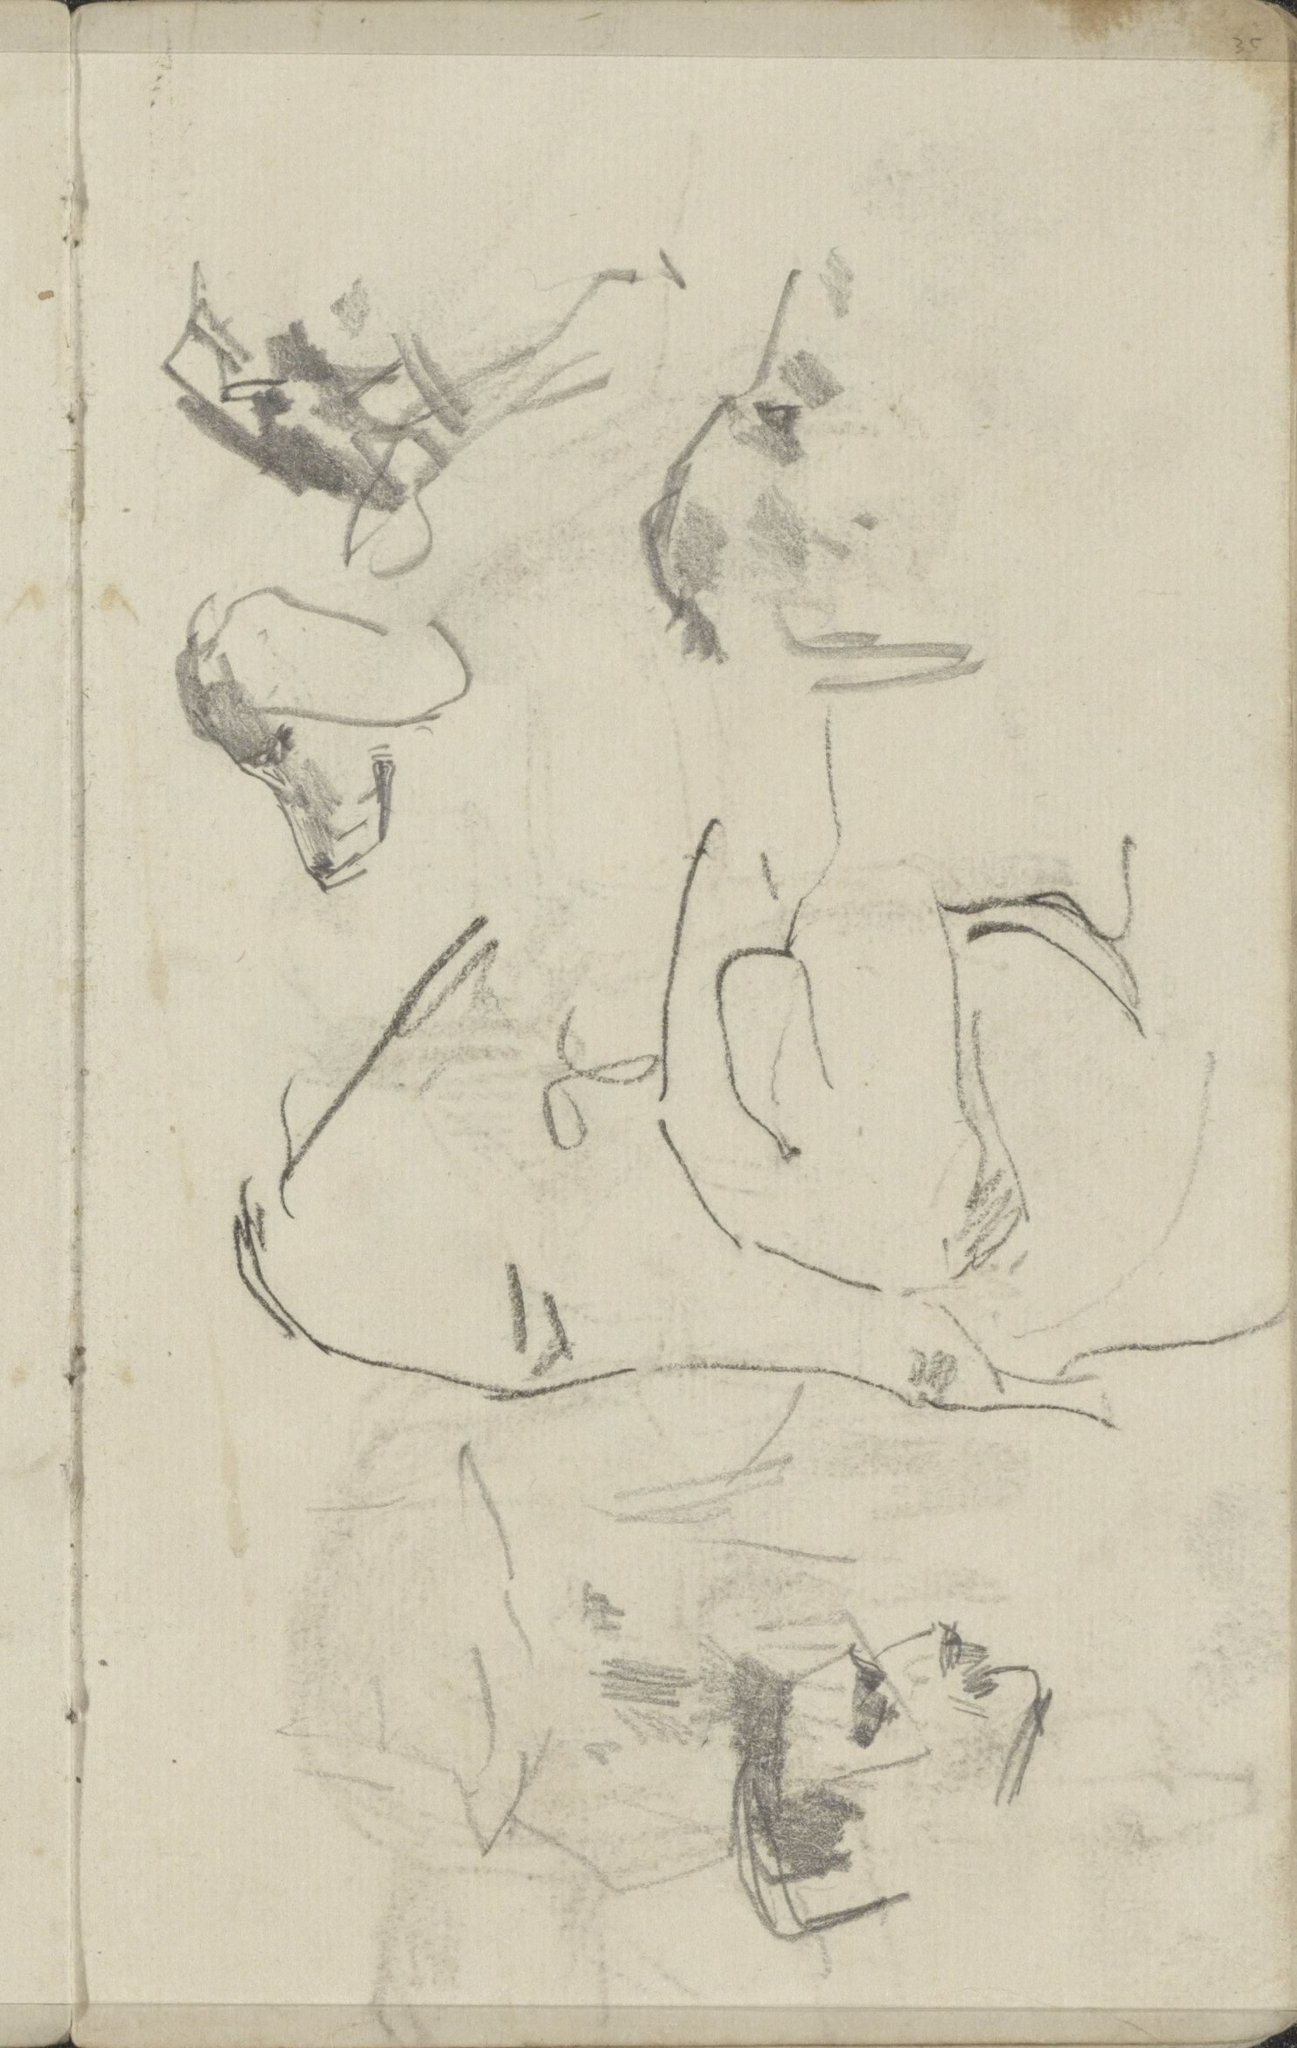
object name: sketchbook leaf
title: Studieblad met honden, mannenhoofden en achterlijven van paarden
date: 1881-1883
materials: chalk, paper, pencil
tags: head (human), horse, dog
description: Pagina 35 uit een schetsboek met 29 bladen.